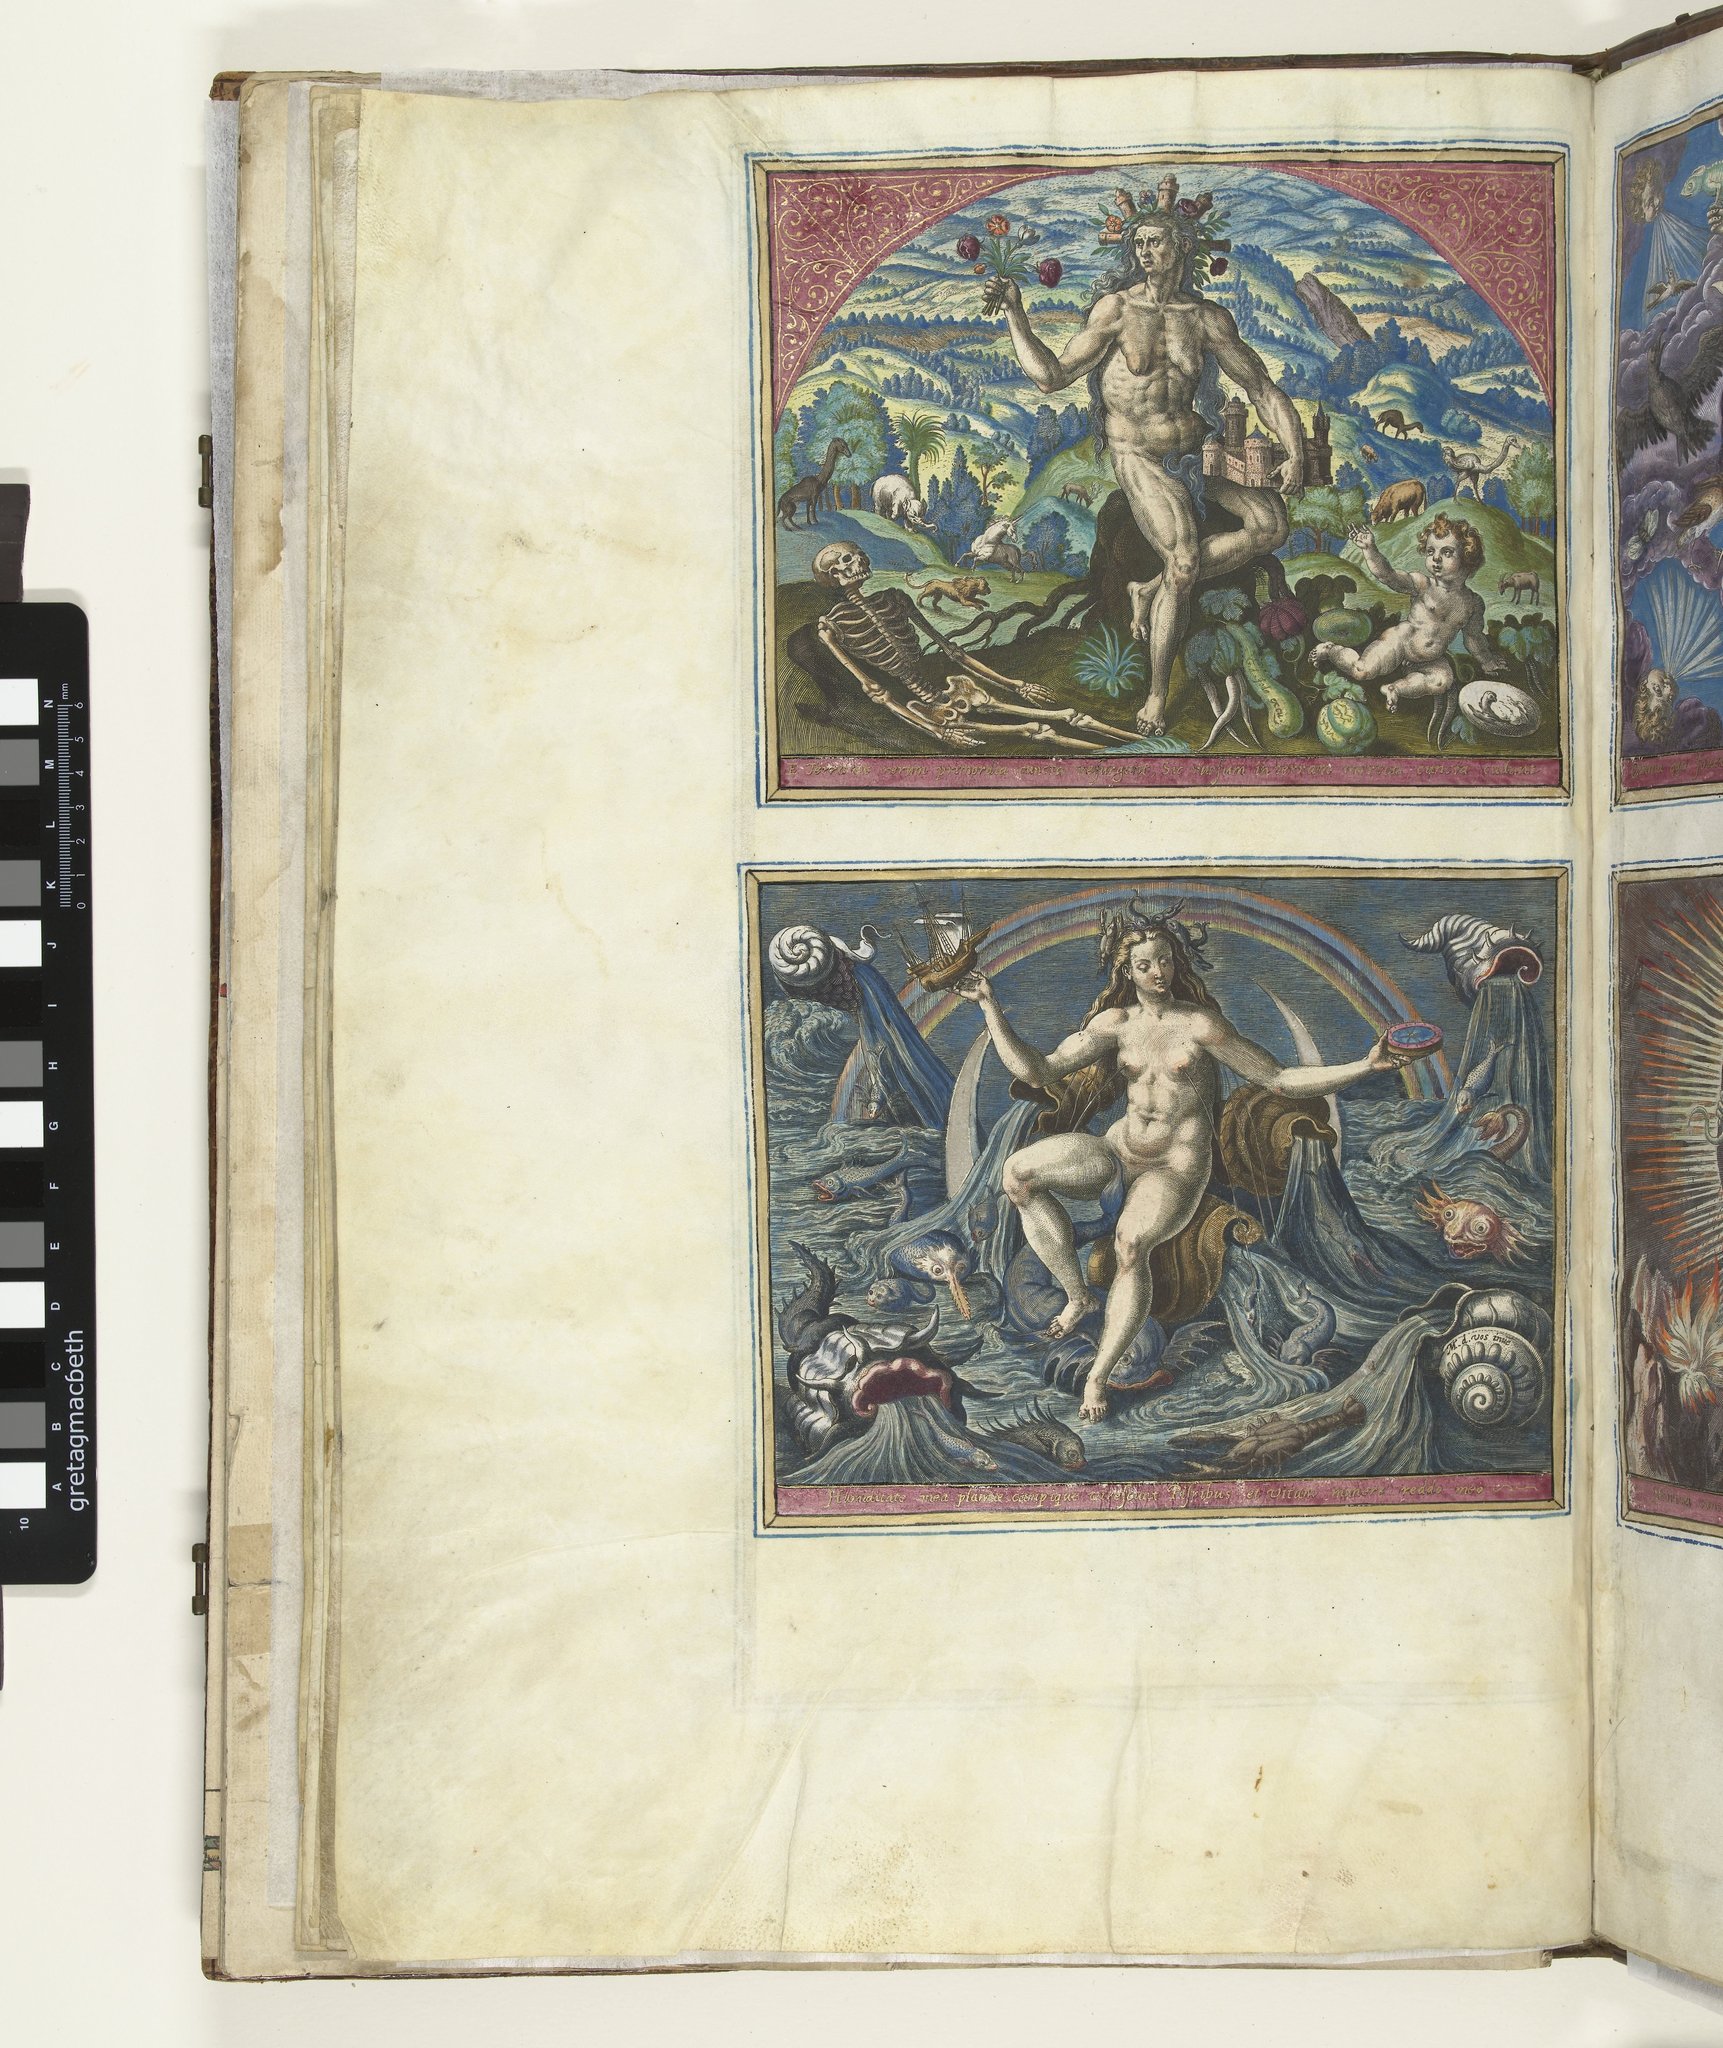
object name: album leaf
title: Water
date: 1580-1584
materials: paper, parchment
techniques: engraving, hand coloring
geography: antwerp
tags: fabulous animals ~ fishes, water (one of the four elements), fishes, venus, standing on a shell, sails with her veil over the water (alternatively she is riding on a dolphin): venus marina, rainbow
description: Het element water, gepersonifieerd door Venus als watergodin. Zij is omringd door water met allerlei vissen en zeewezens. In haar ene hand een kompas, in haar andere hand een schip. Uit haar borsten en uit haar haren stroomt water. Ook uit schelpen en urnen rondom haar stroomt water. Onder de voorstelling een vers in het Latijn. Deze prent maakt deel uit van een album.